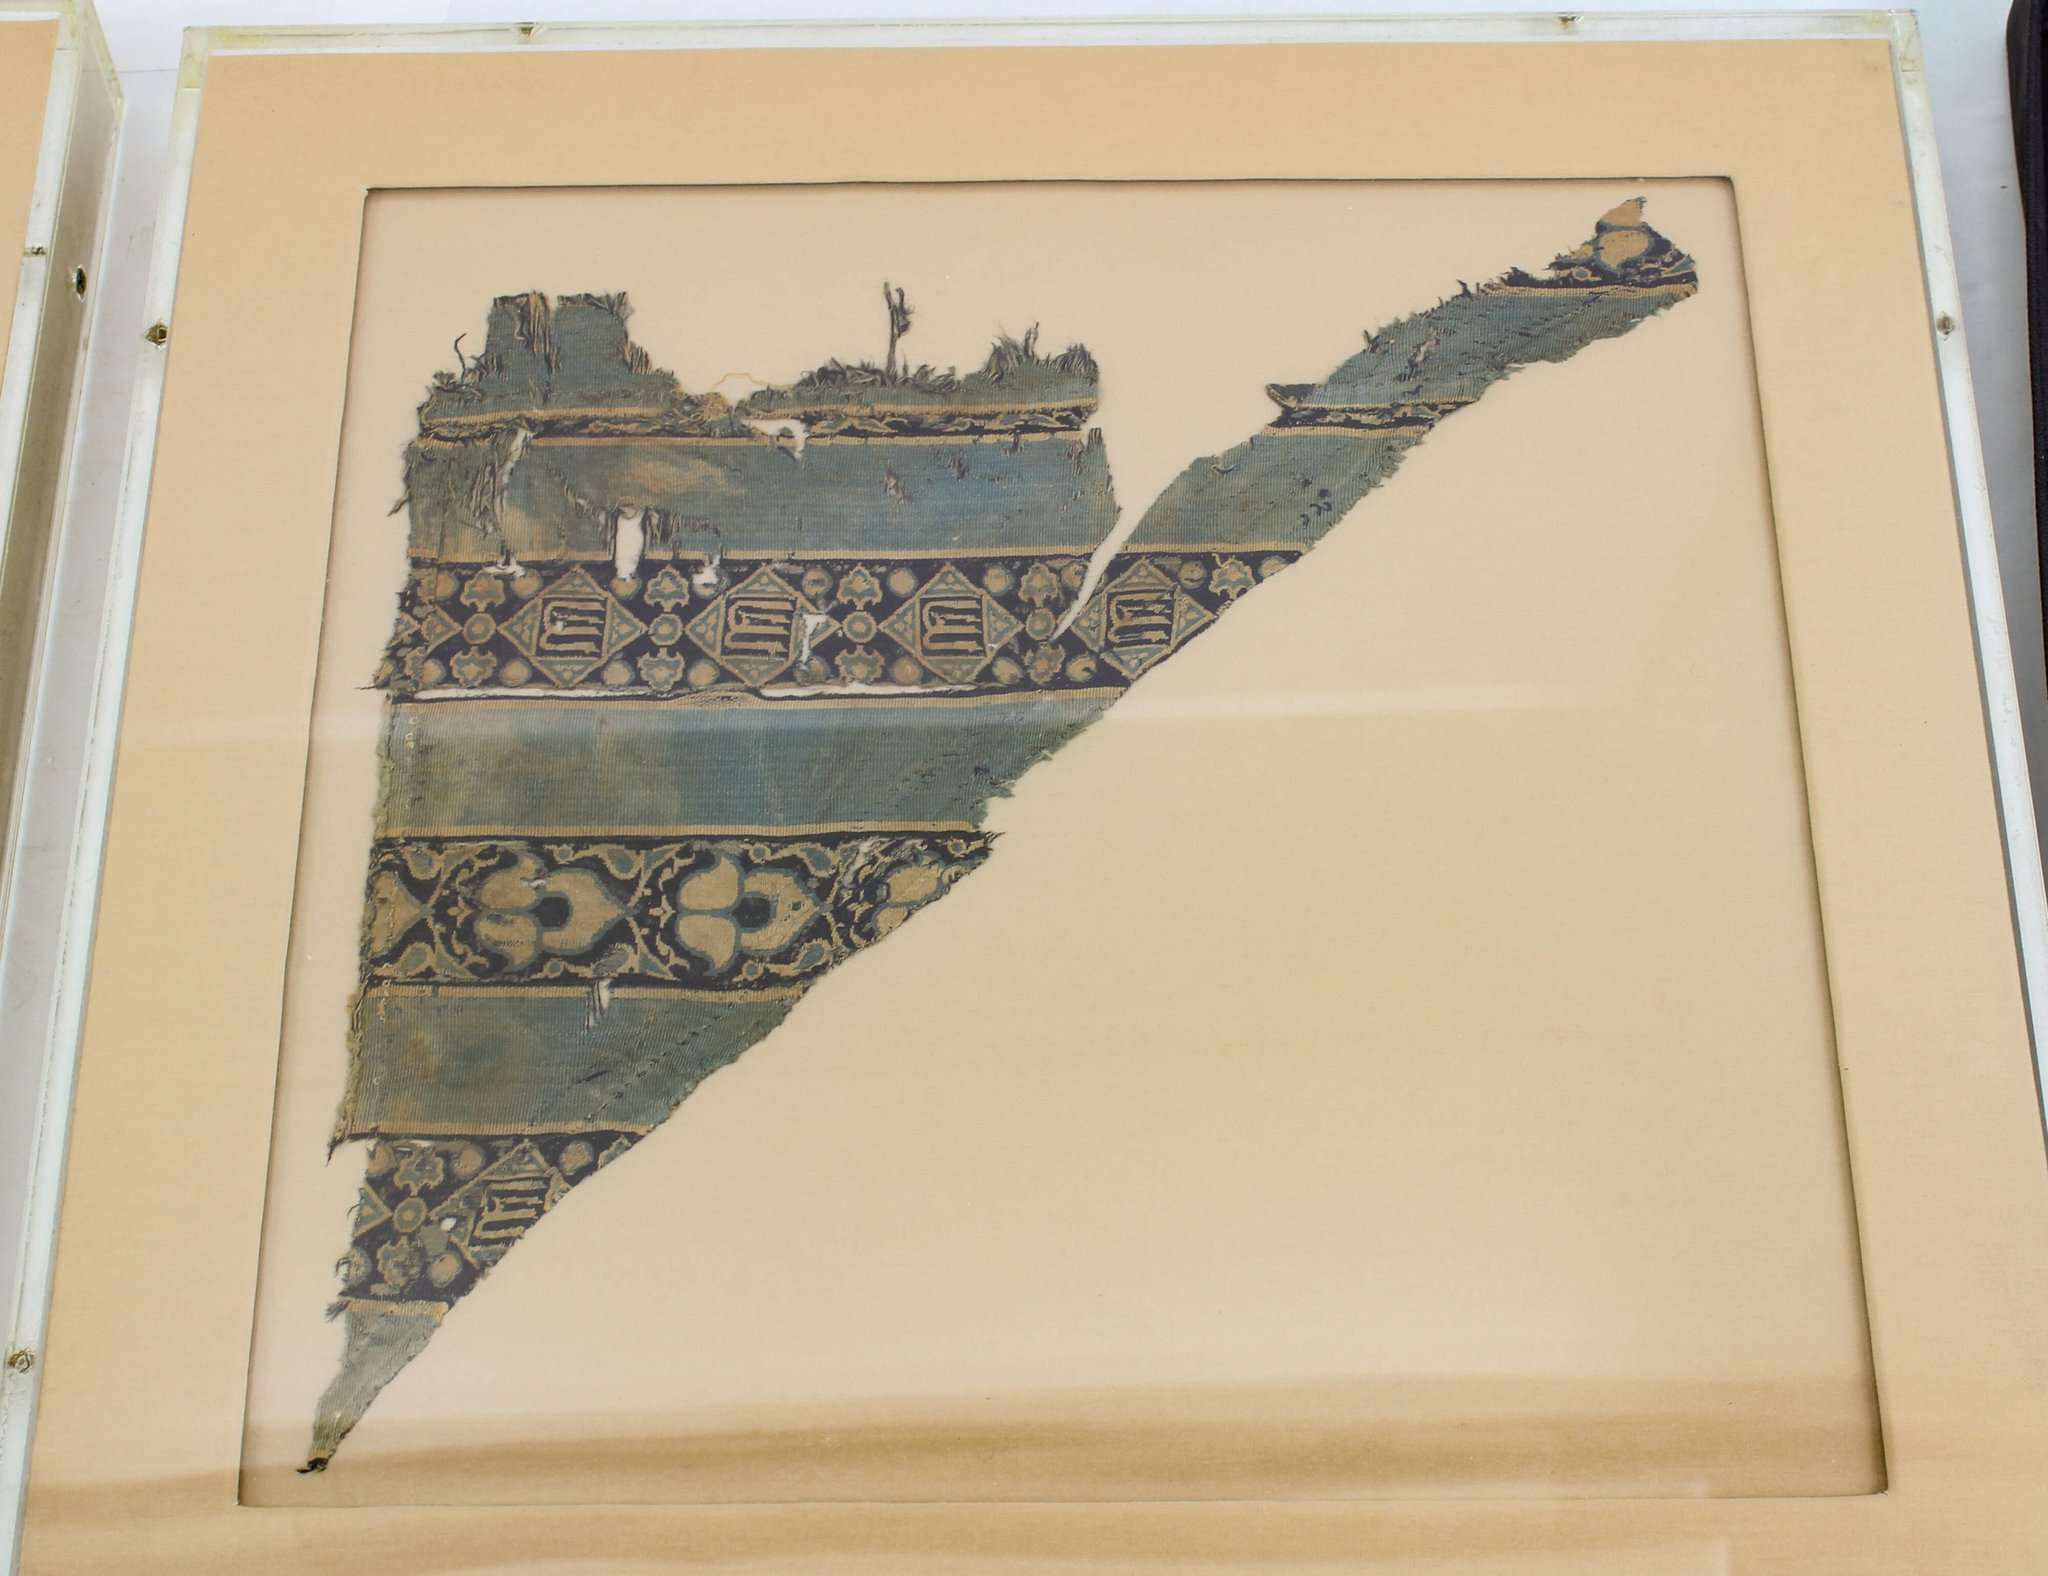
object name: textile fragment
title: Three Textile Fragments in Two Mounts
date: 1301-1400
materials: silk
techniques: weave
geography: egypt